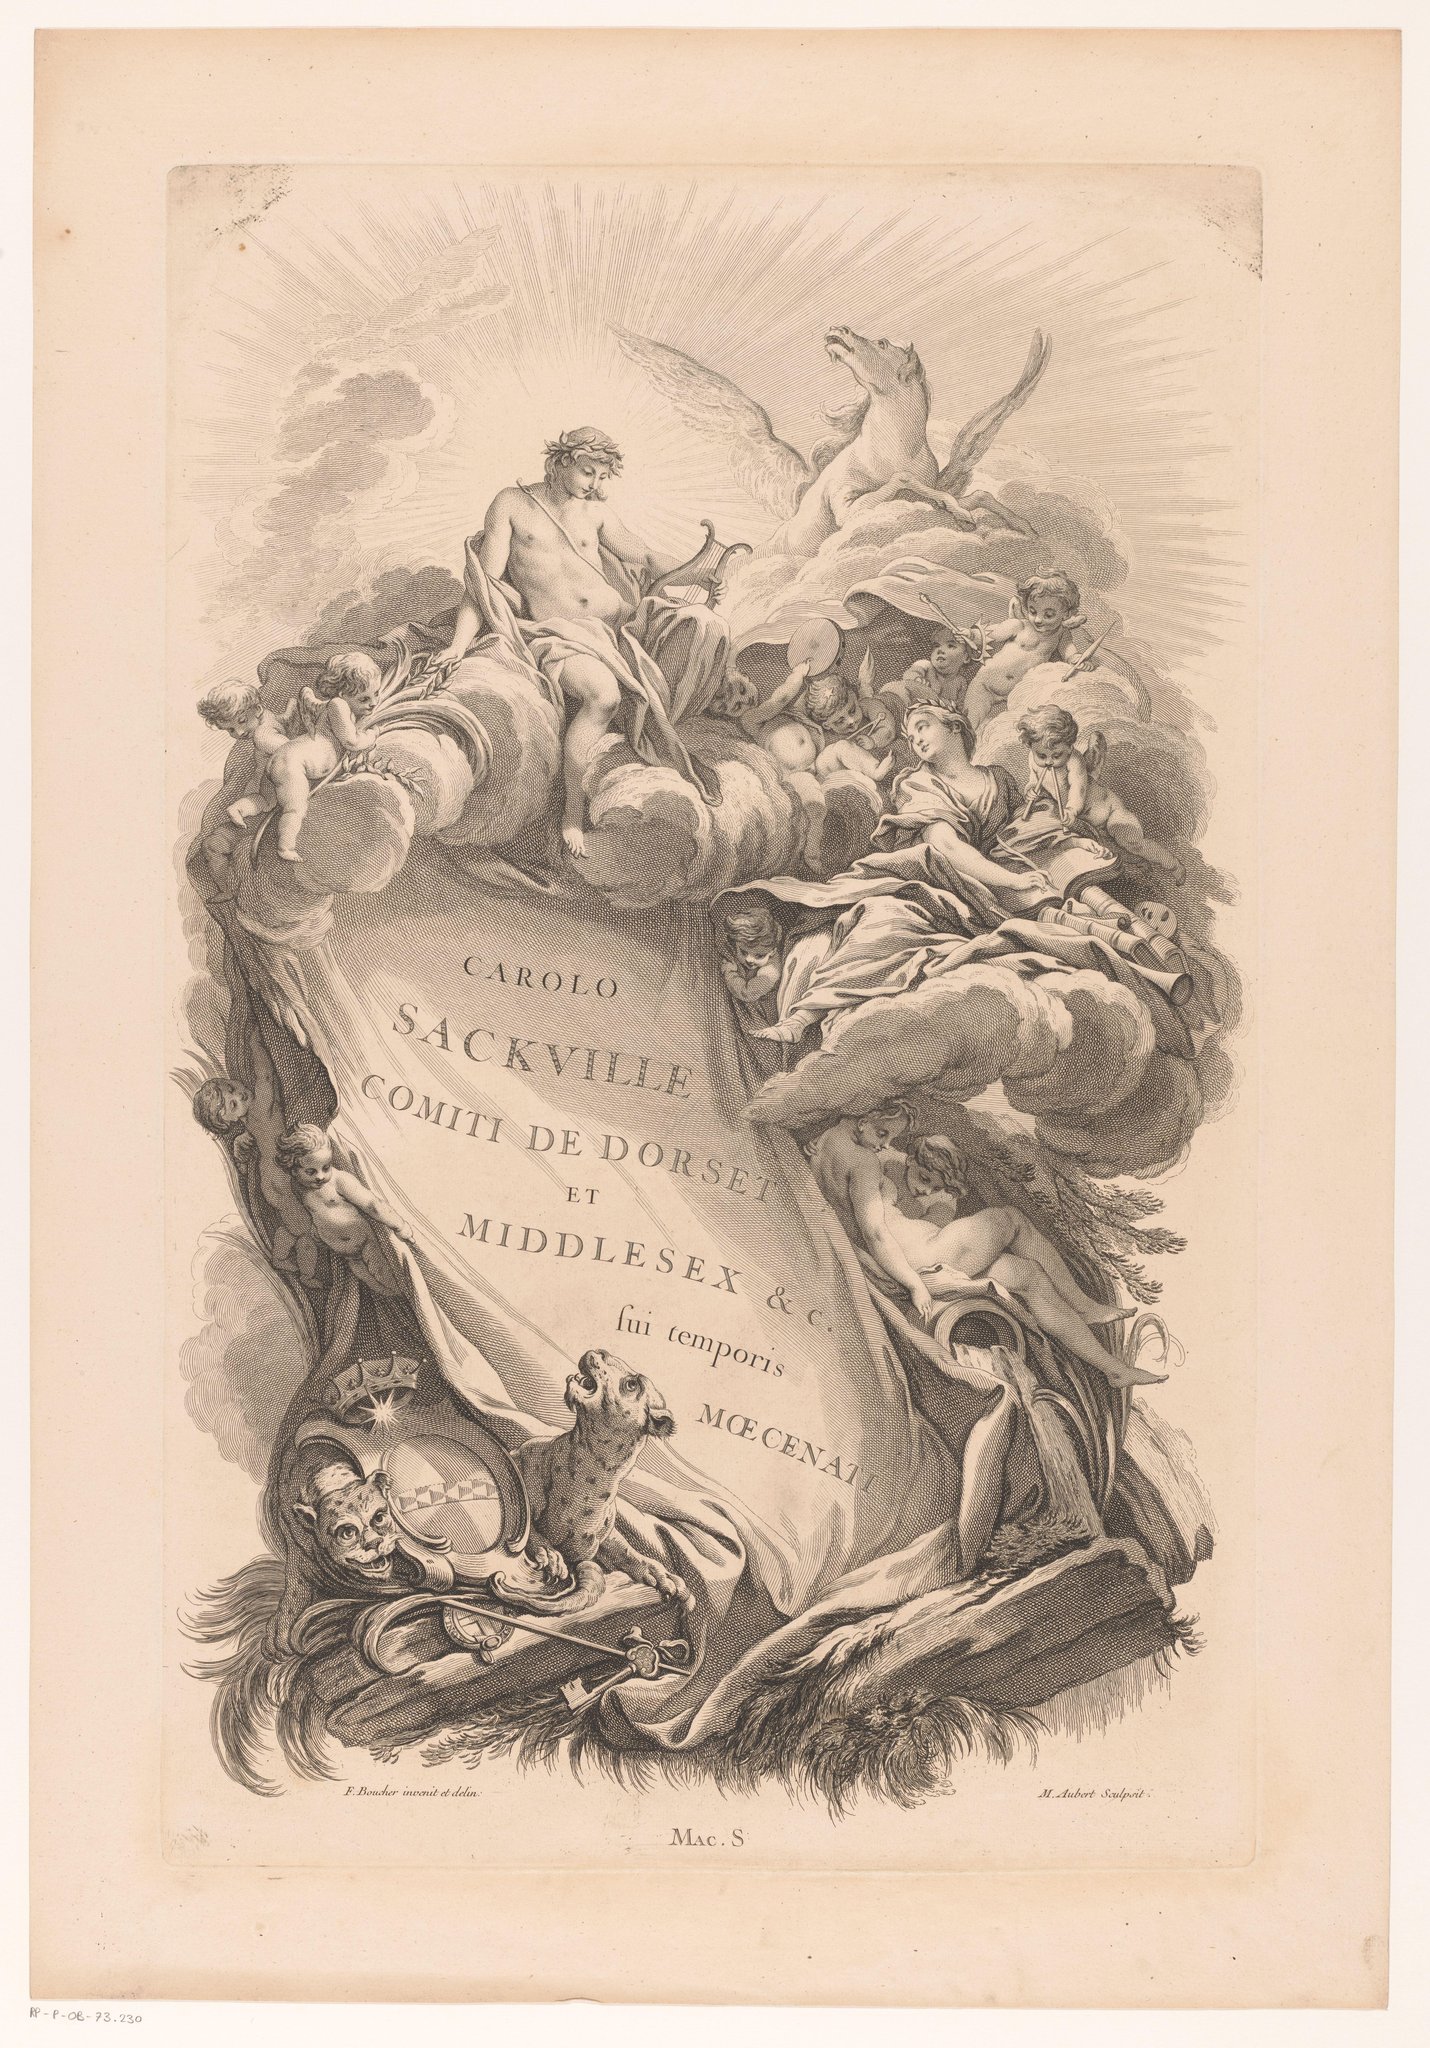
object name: print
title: Tombeaux des princes et des grands capitaines et autres hommes illustres qui ont fleuri dans la Grande Bretagne vers la fin du XVIIe et le commencement du XVIIIe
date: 1735-1741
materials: paper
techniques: engraving, etching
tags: earl, pegasus, the winged horse, beasts of prey, predatory animals: leopard, (story of) apollo (phoebus)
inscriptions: collector's mark: Lugt 2228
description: Maakt deel uit van een twintigdelige serie met prenten van grafmonumenten van illustere Britten naar schilderijen uit de collectie van de Duke of Richmond. De serie bestaat uit prenten door verschillende kunstenaars en werd eerst uitgegeven door Mac Swiny en daarna door Basan. Dit betreft de prent voorafgaand aan het allegorisch grafmonument voor Charles Sackville, zesde graaf van Dorset.